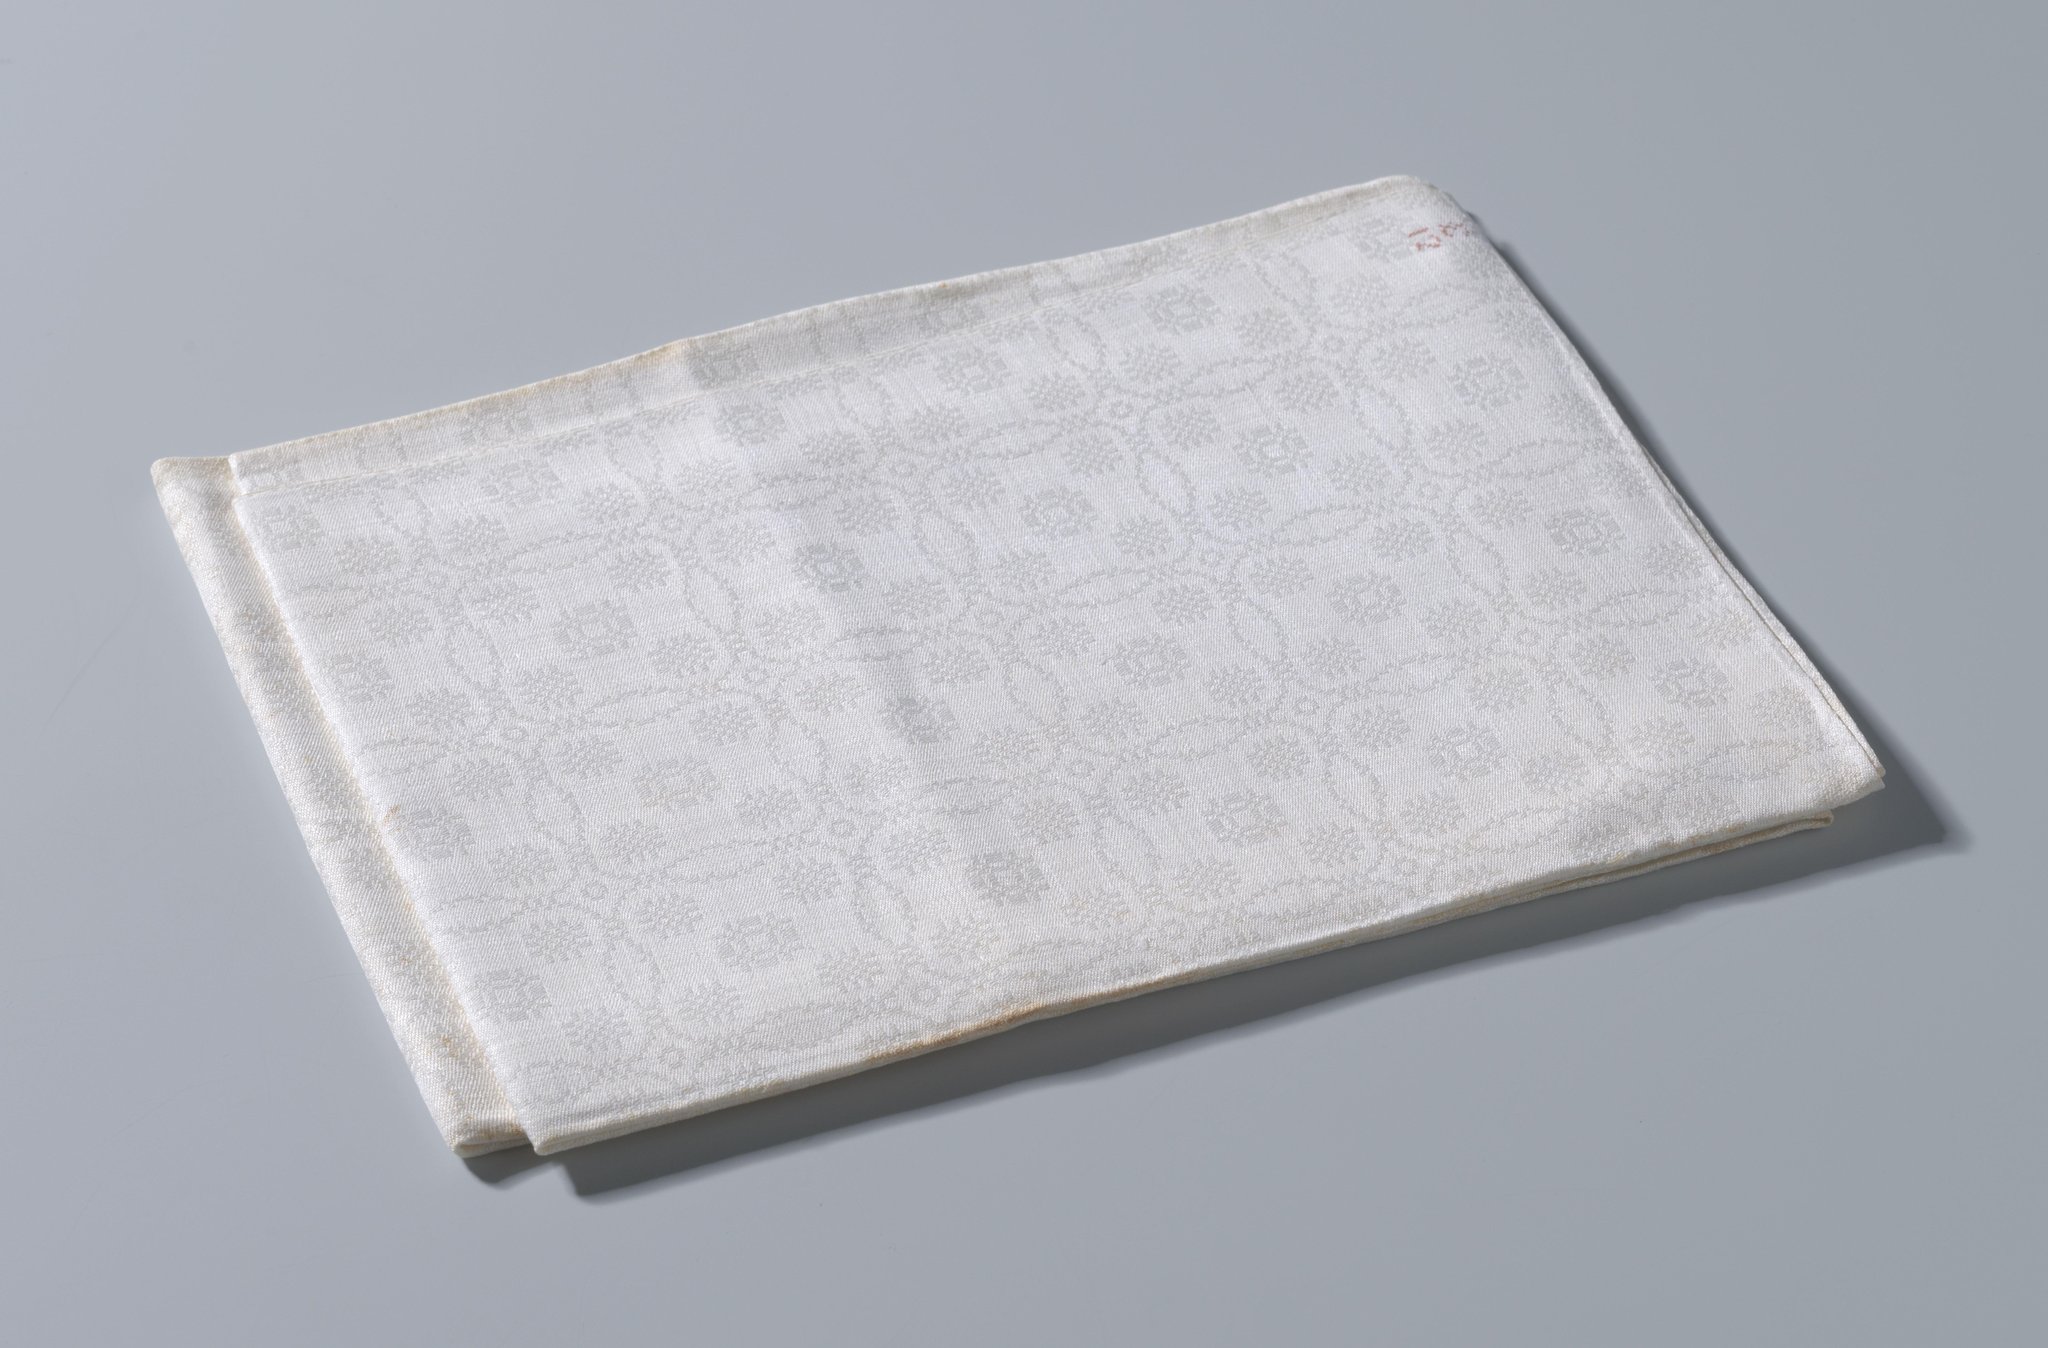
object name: napkin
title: Servet van pellendamast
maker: Anonymous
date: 1700-1800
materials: linen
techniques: weave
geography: netherlands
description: Servet van pellendamast. Het servet is gemerkt: E12. Bij het servet hoort een servet met invnr. BK-1980-120-A.